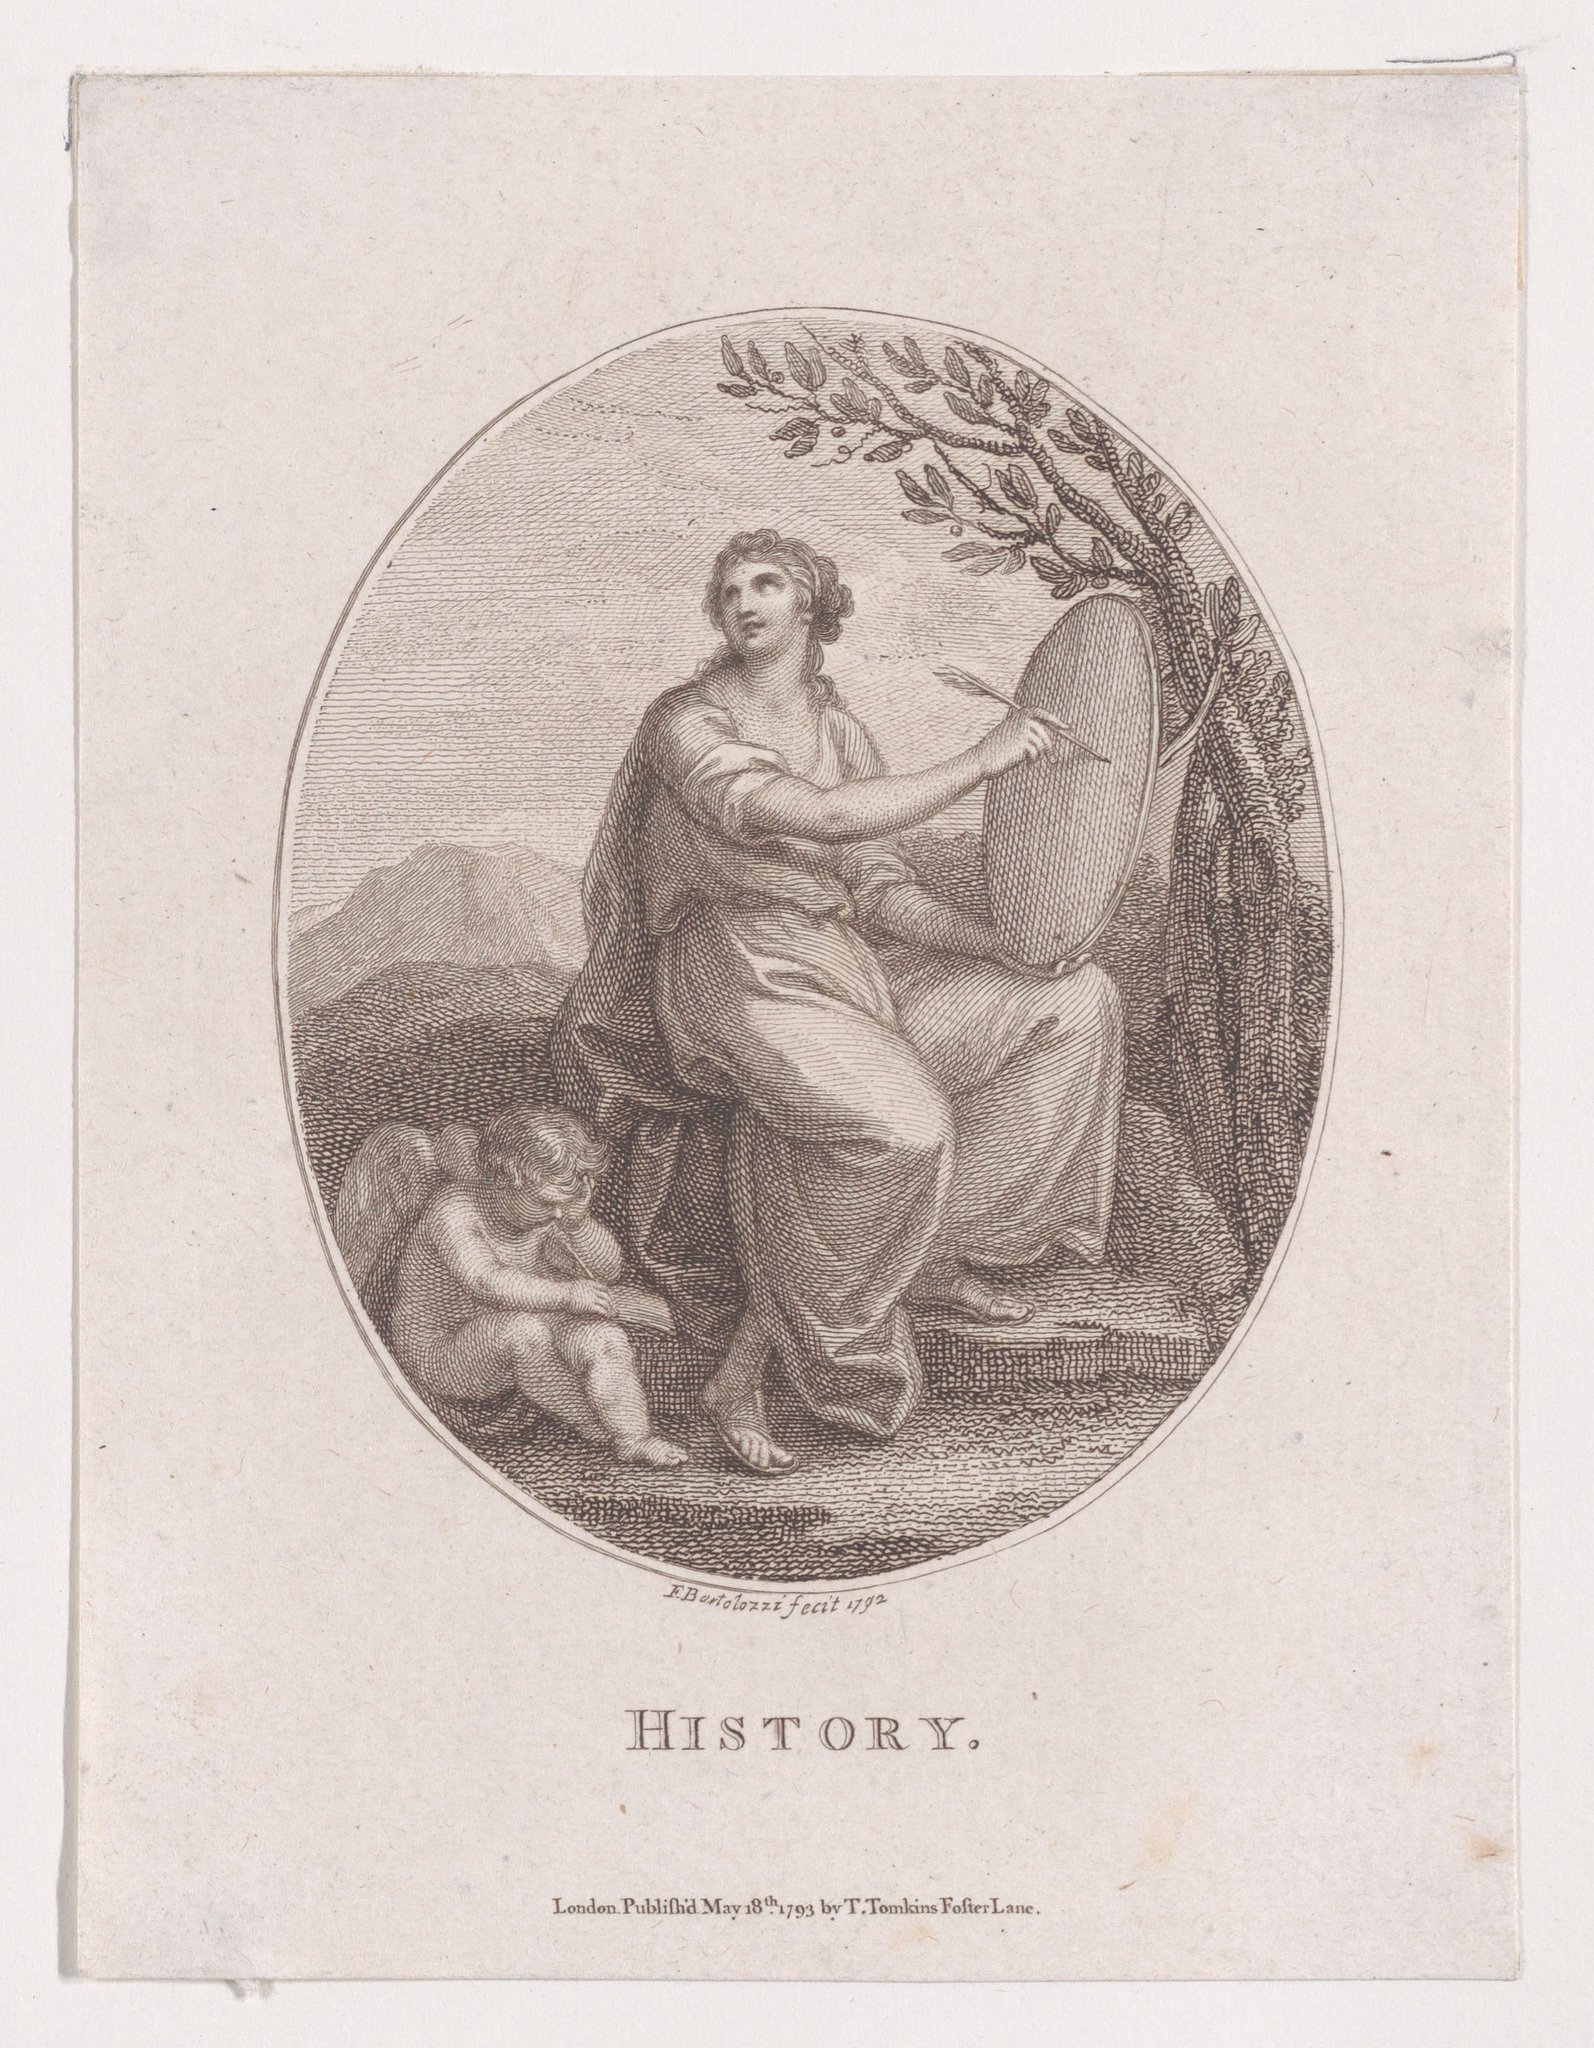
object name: print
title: History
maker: francesco bartolozzi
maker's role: artist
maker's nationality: italian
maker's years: 1728-1815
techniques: engraving, etching